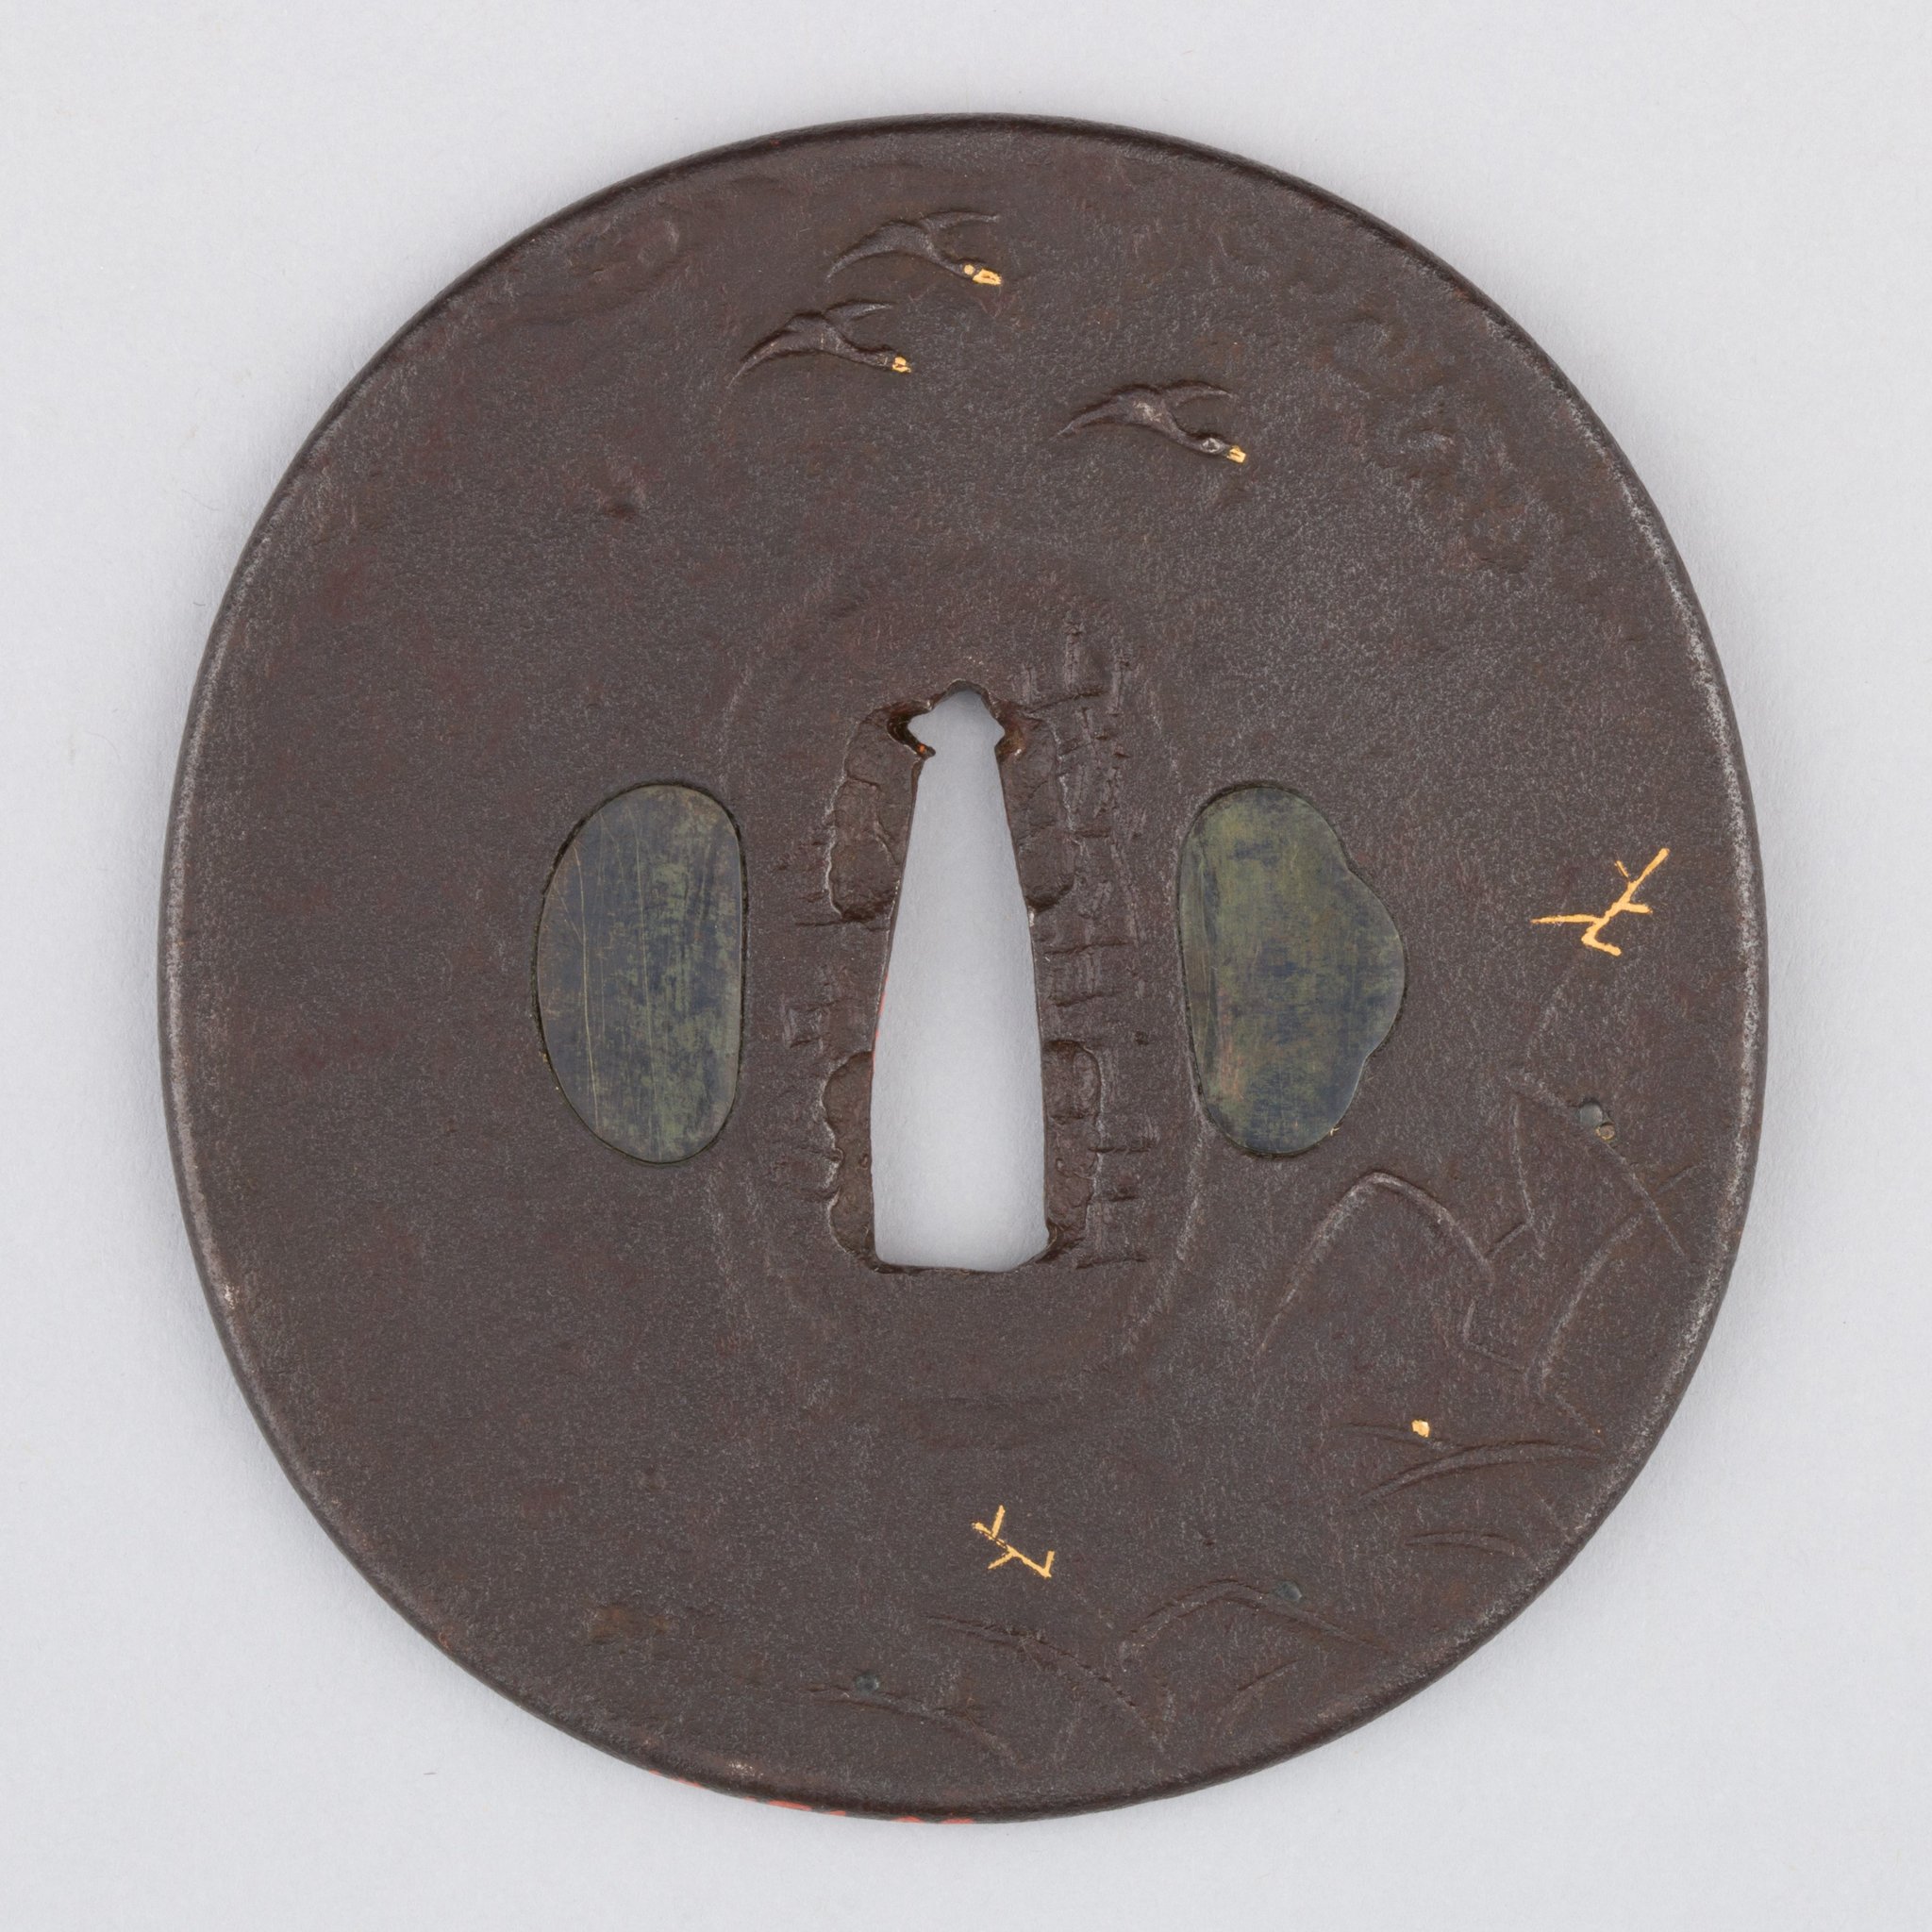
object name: sword guard tsuba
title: Sword Guard (Tsuba)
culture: japanese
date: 1615-1868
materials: copper, iron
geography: japan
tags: geese